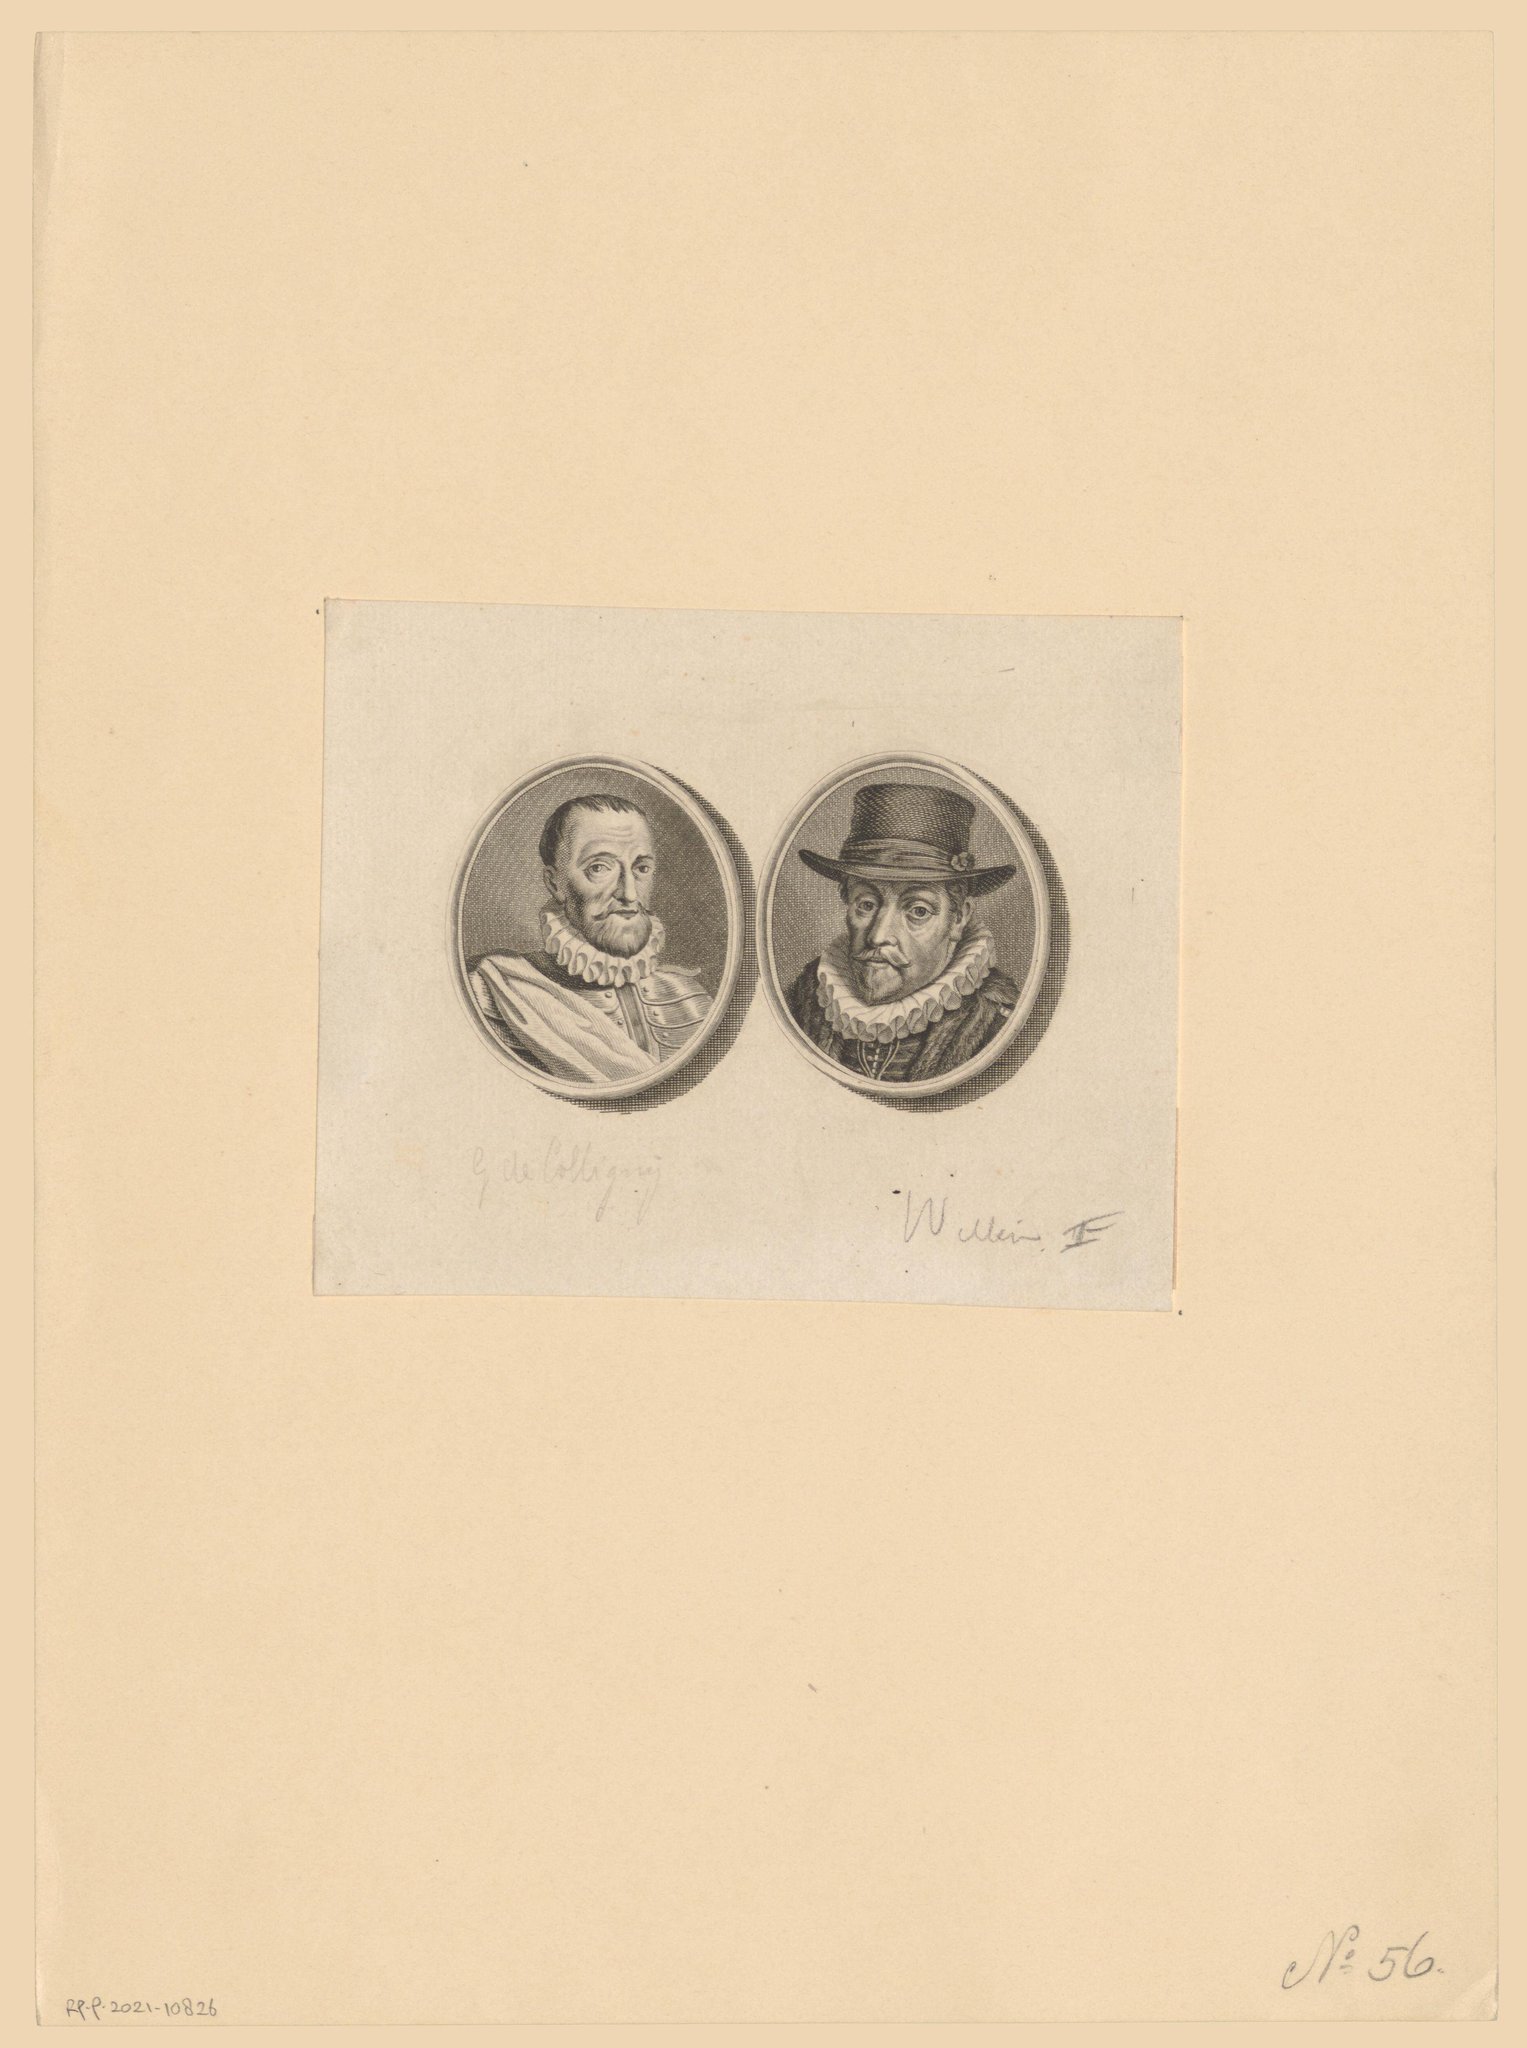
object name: print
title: Portretten van twee onbekende mannen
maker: Anonymous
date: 1650-1749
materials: paper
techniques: engraving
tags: adult man, historical persons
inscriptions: collector's mark: Lugt 963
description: Mogelijk gaat het om Gaspar de Coligny en Willem van Oranje.